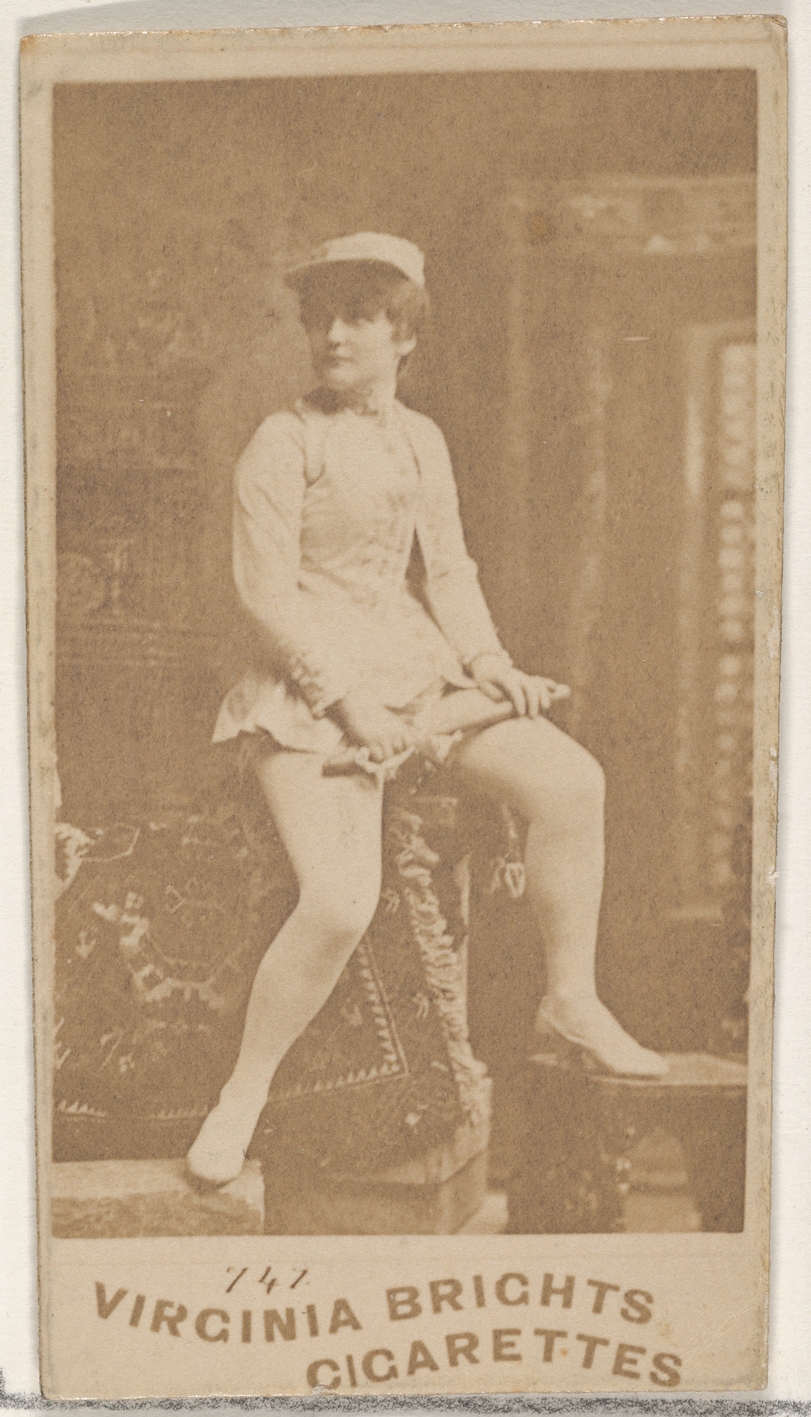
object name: photograph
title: Card 747, from the Actors and Actresses series (N45, Type 4) for Virginia Brights Cigarettes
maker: allen & ginter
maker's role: publisher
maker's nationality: american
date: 1888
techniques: albumen silver print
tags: portraits,women,actresses